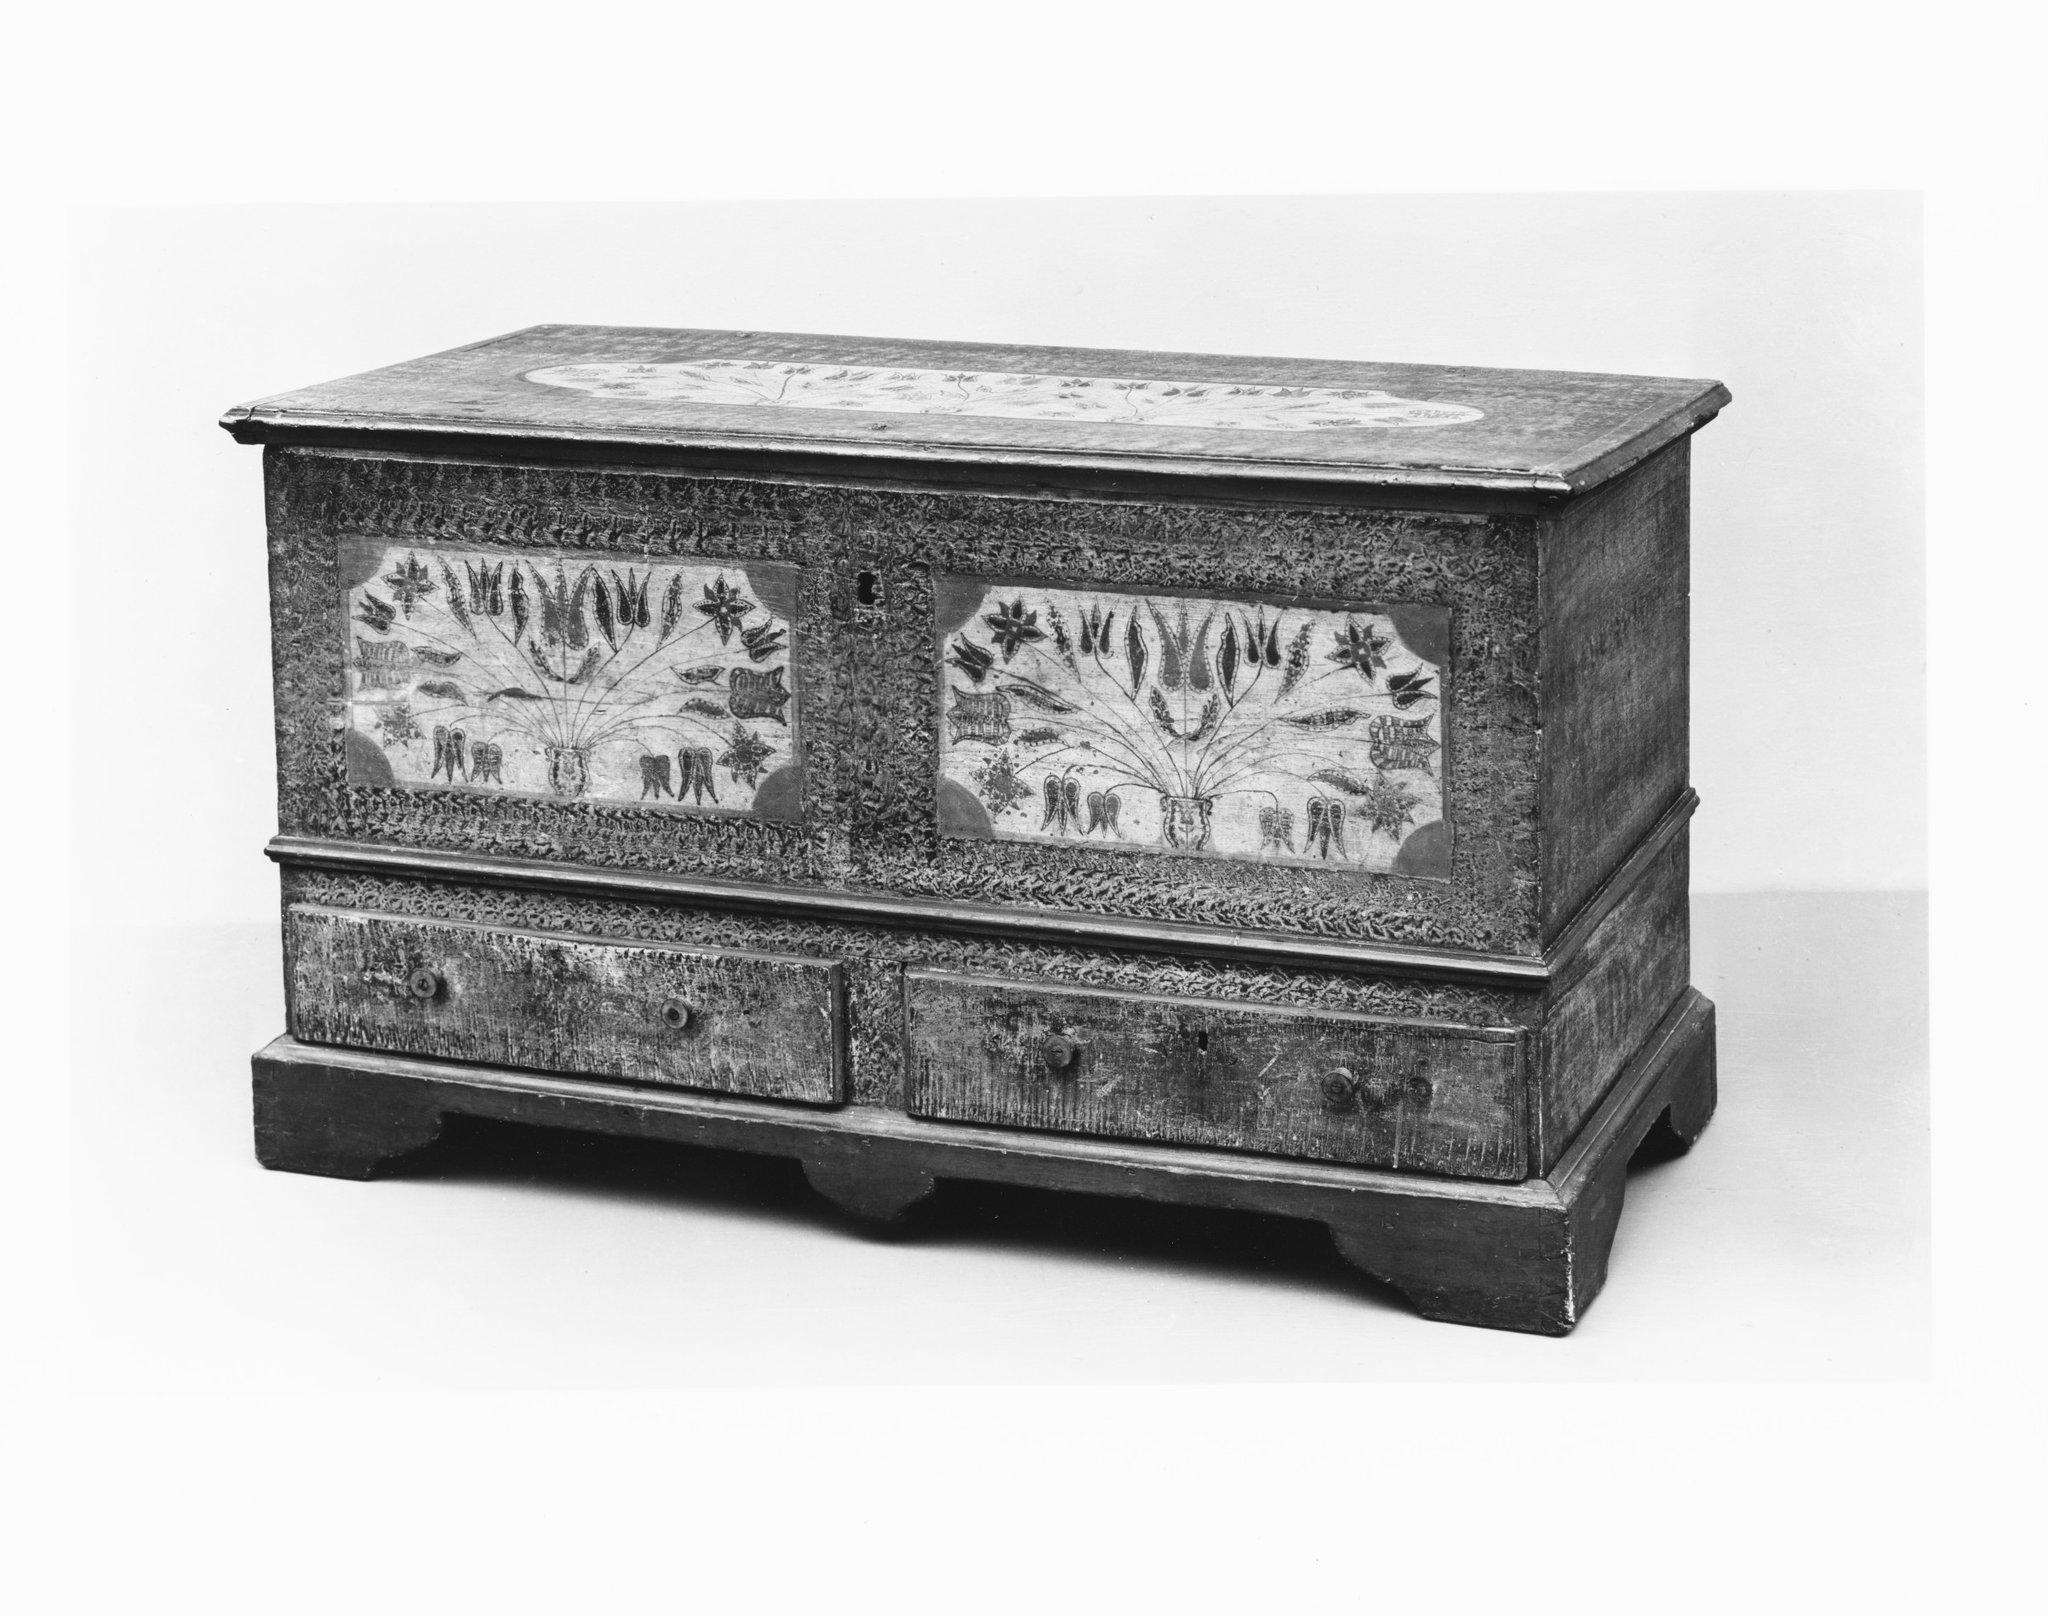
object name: dower chest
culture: american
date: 1800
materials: wood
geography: united states